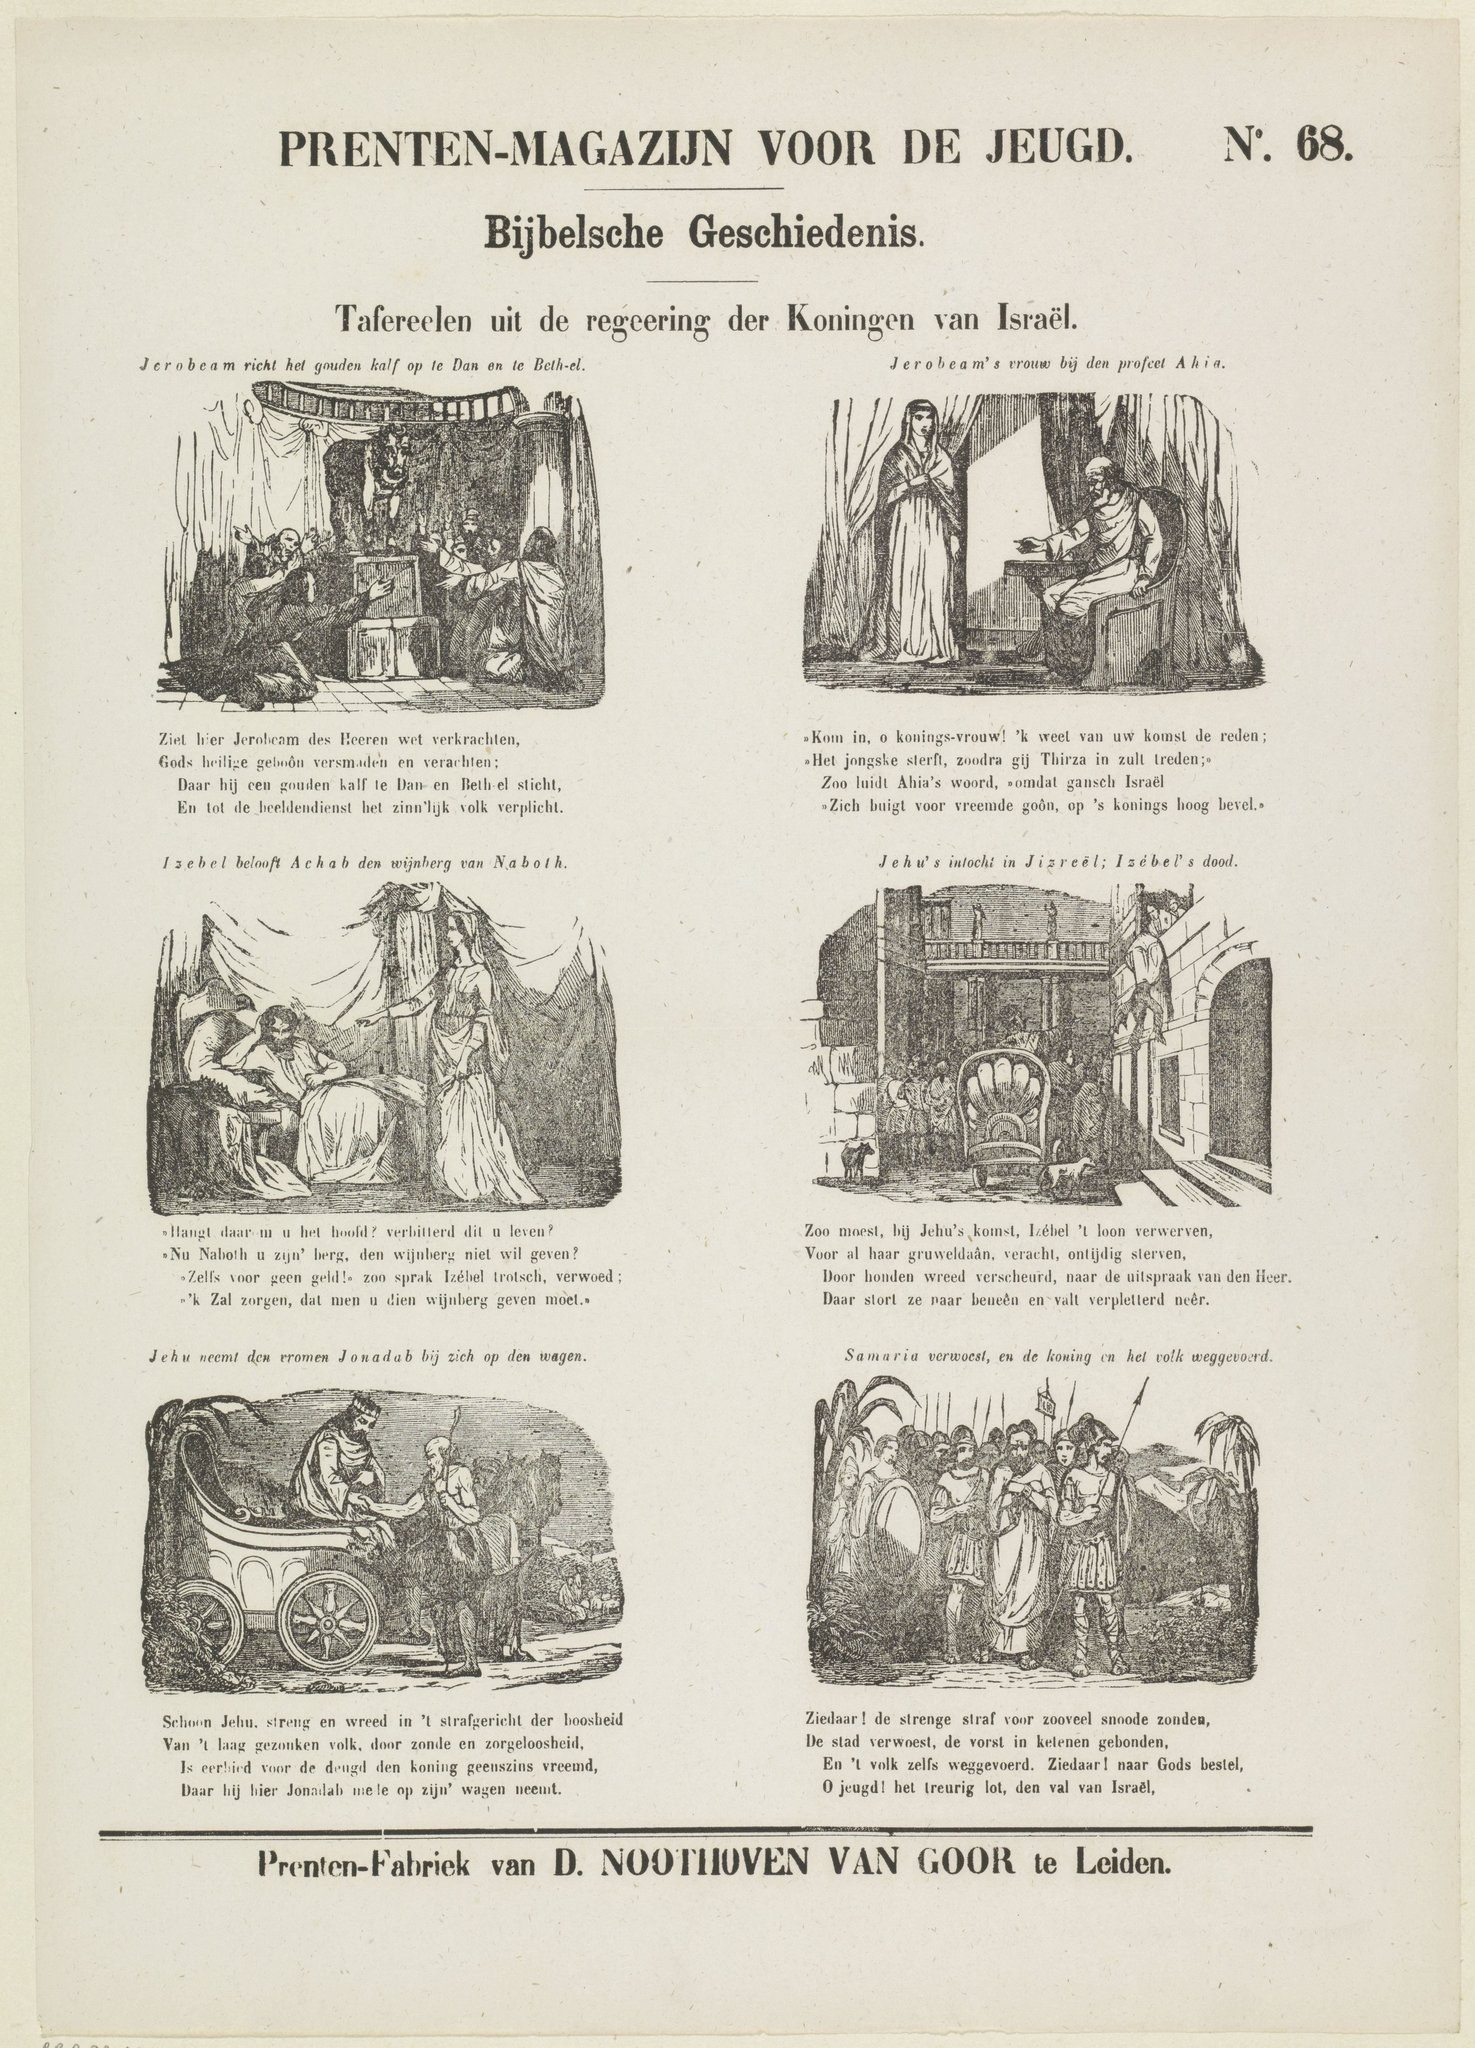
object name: popular print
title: Tafereelen uit de regeering der koningen van Israël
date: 1850-1881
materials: paper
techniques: letterpress printing, engraving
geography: netherlands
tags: jeroboam's wife in disguise visits the old and blind ahijah, but he, having been warned by god, recognizes her; he predicts the death of her son and israel's punishment for jeroboam's sin, jeroboam sets up two golden calves, one in bethel and one in dan, the fall of samaria (2 kings 17:5-6), jehu meets jehonadab who promises to support him, jezebel comforts ahab, old testament, jezebel is thrown from the window by two eunuchs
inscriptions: collector's mark: Lugt 2760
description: Blad met 6 voorstellingen over de regeringsperioden van de oudtestamentische koningen van Israël. Boven elke voorstelling een titel en onder elke voorstelling een vierregelig vers. Genummerd rechtsboven: No. 68.